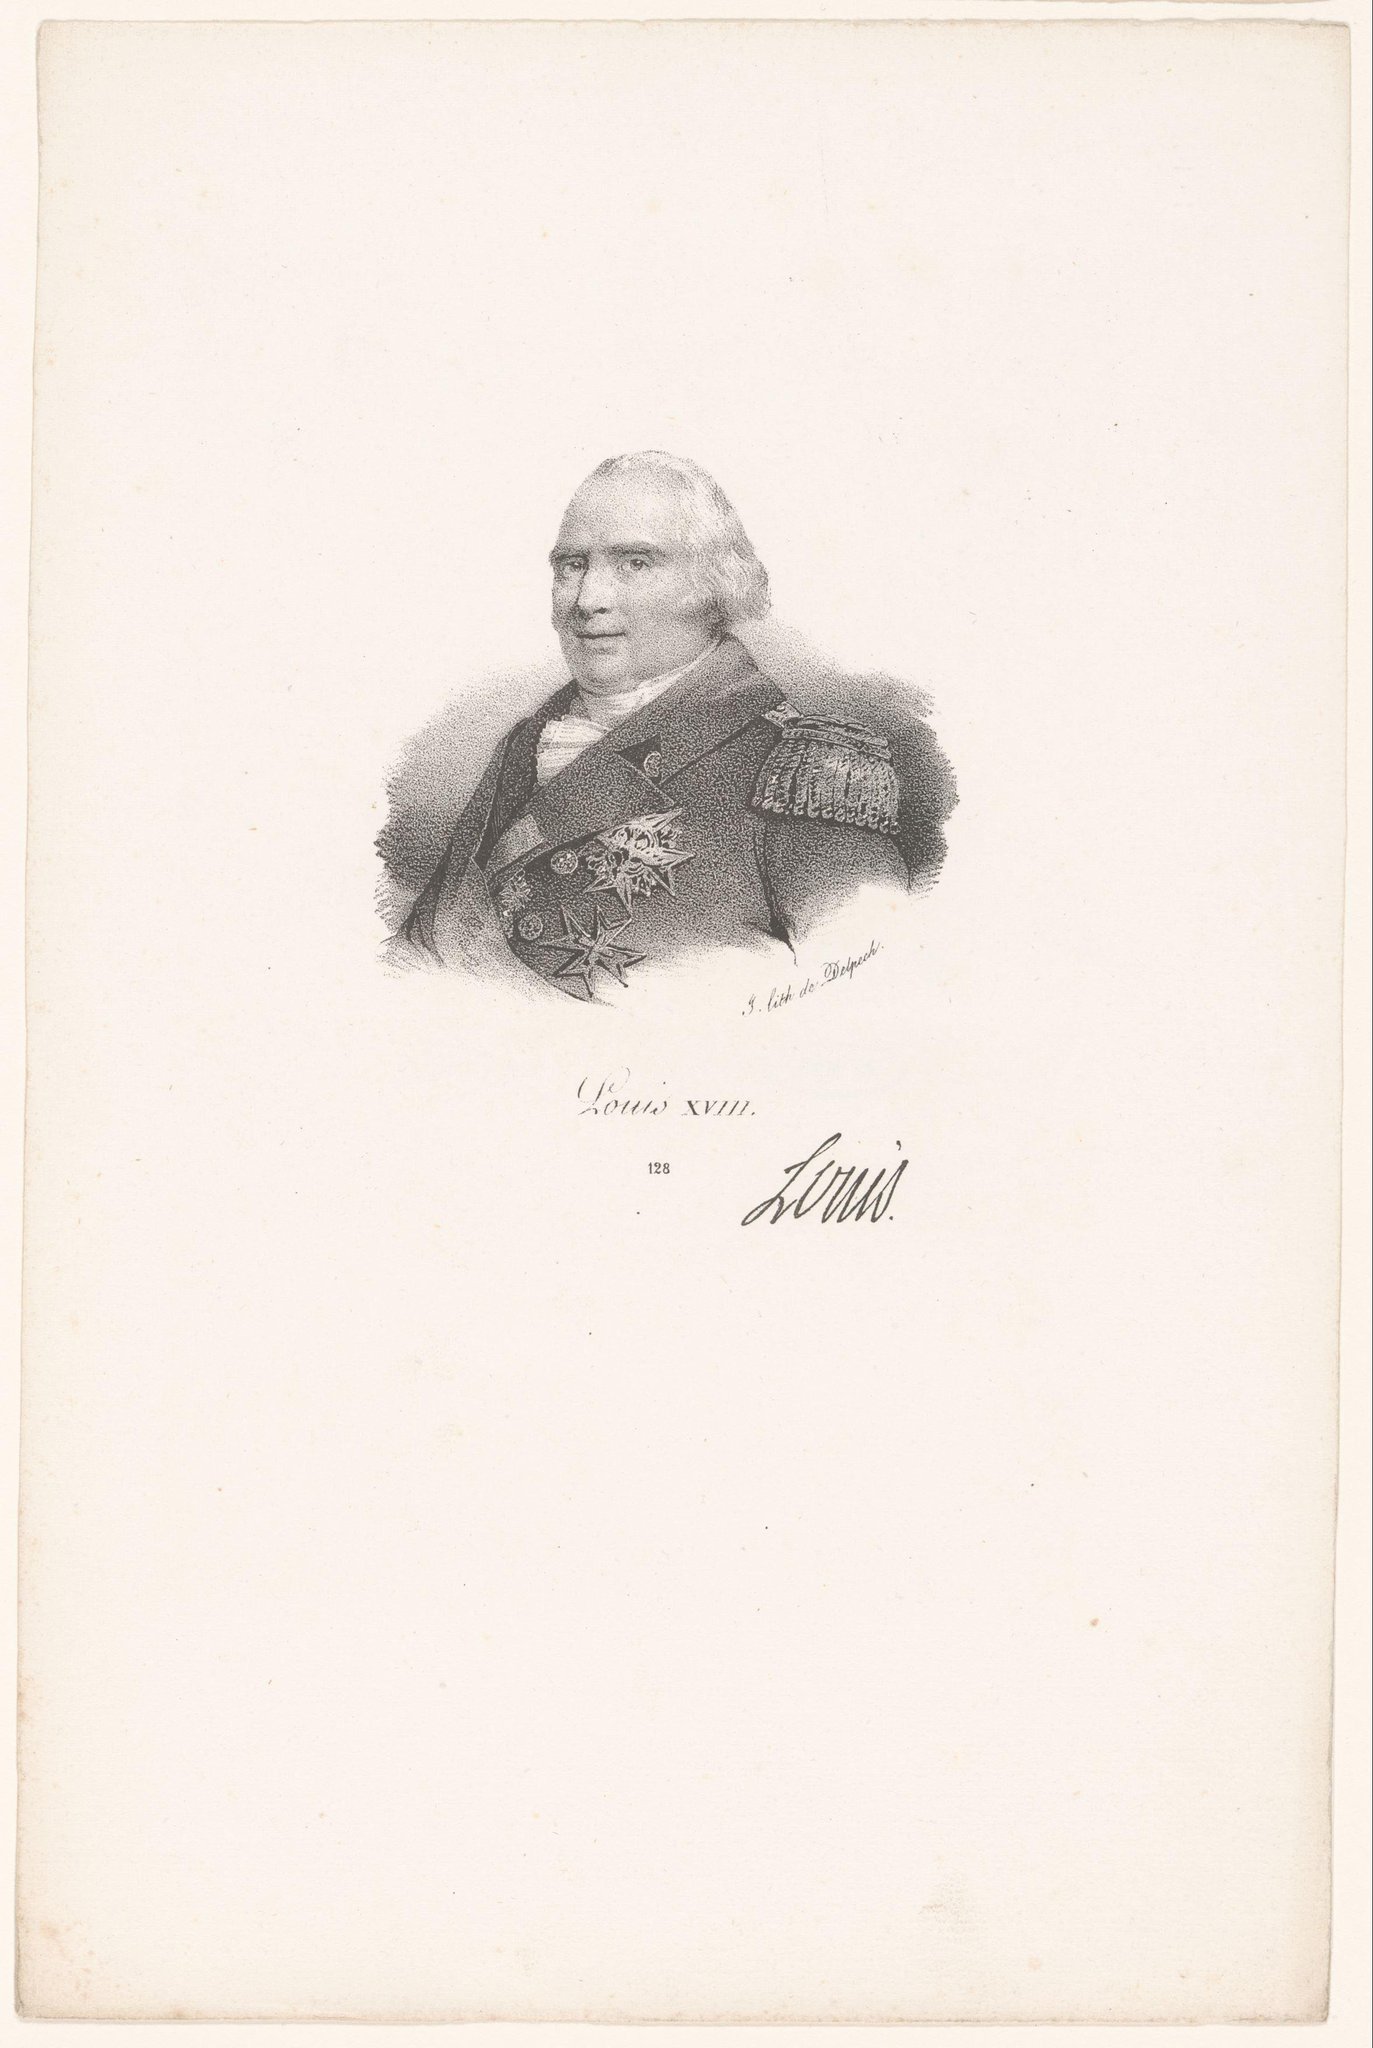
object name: print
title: Louis XVIII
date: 1818-1842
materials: paper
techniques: lithograph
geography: paris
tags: lodewijk xviii (koning van frankrijk), historical persons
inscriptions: collector's mark: Lugt 2228a